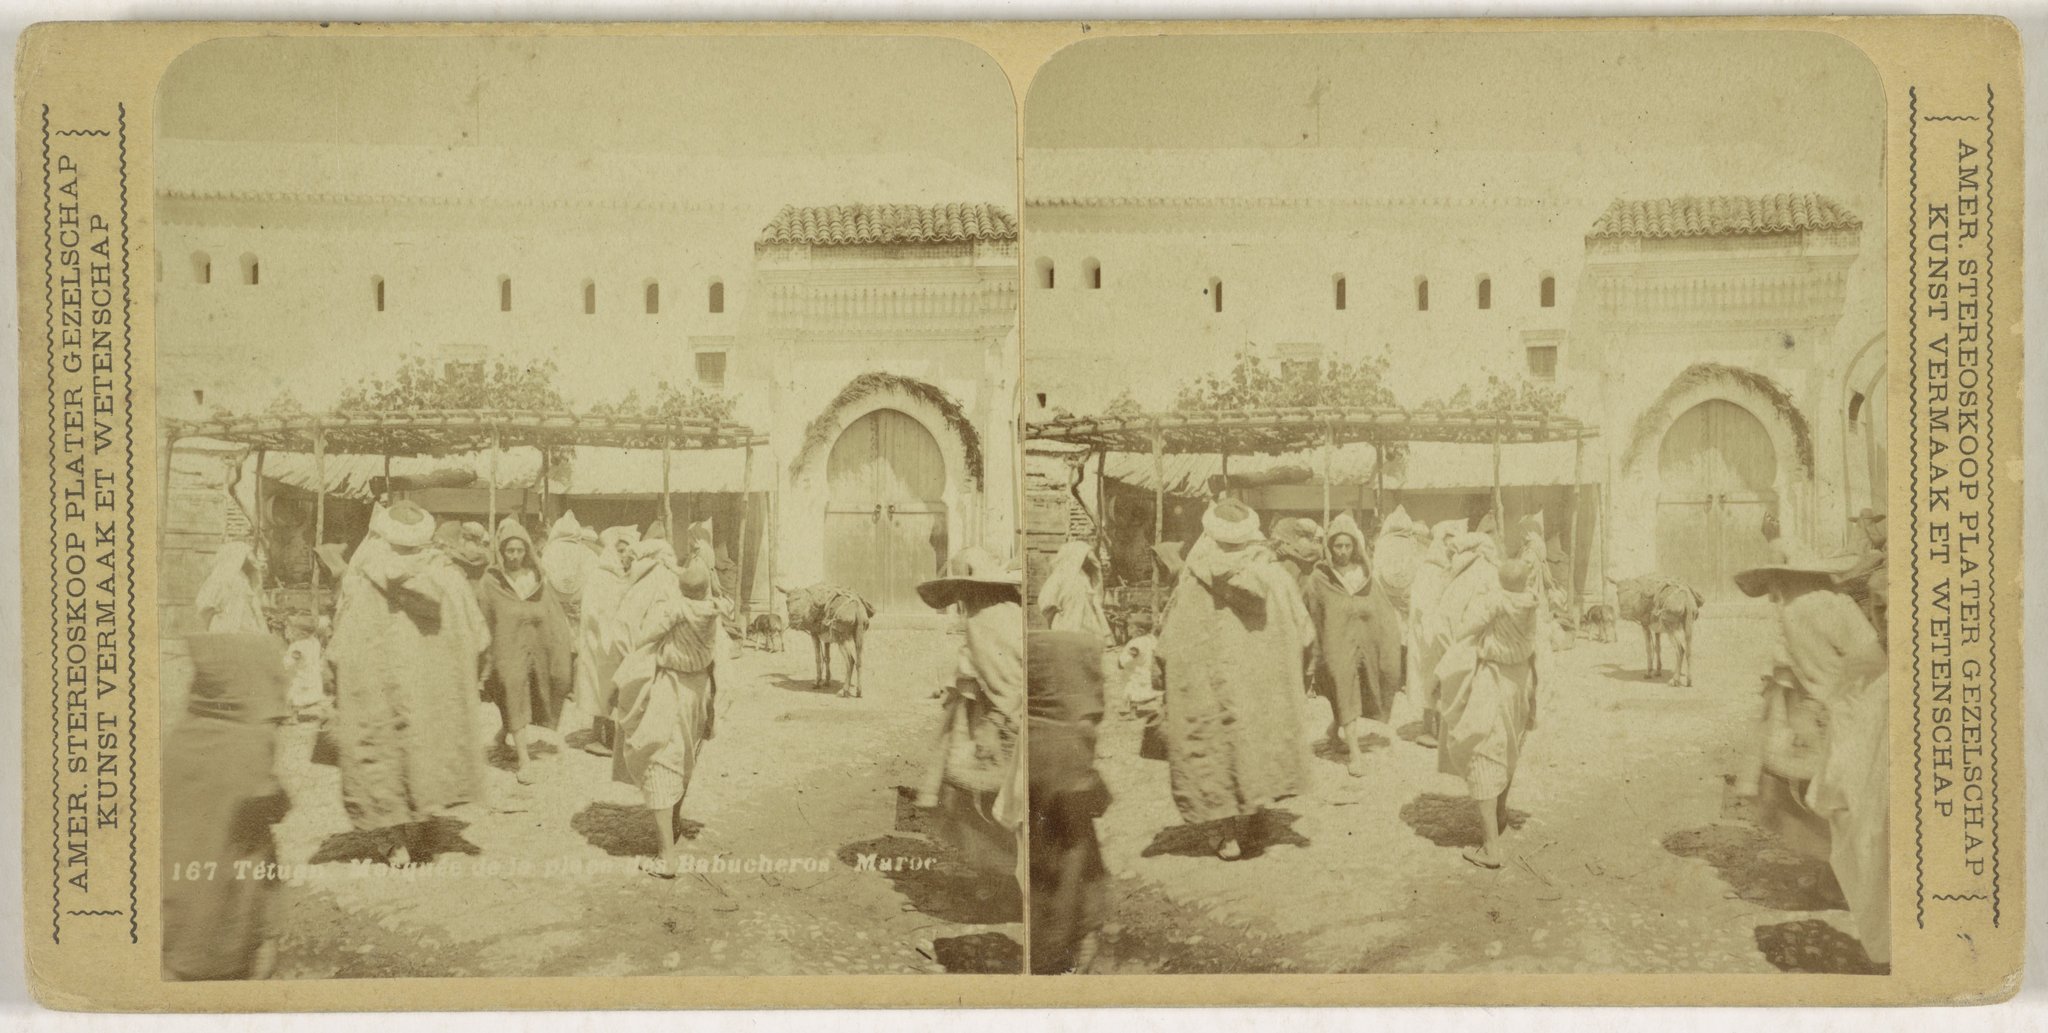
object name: stereograph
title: Tetuan. Mosquee de la place des Babucheros. Maroc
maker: Anonymous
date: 1879-1910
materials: cardboard, paper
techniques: albumen print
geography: tétouan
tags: square, place, circus, etc.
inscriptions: number: ‘264’, number: ‘167’